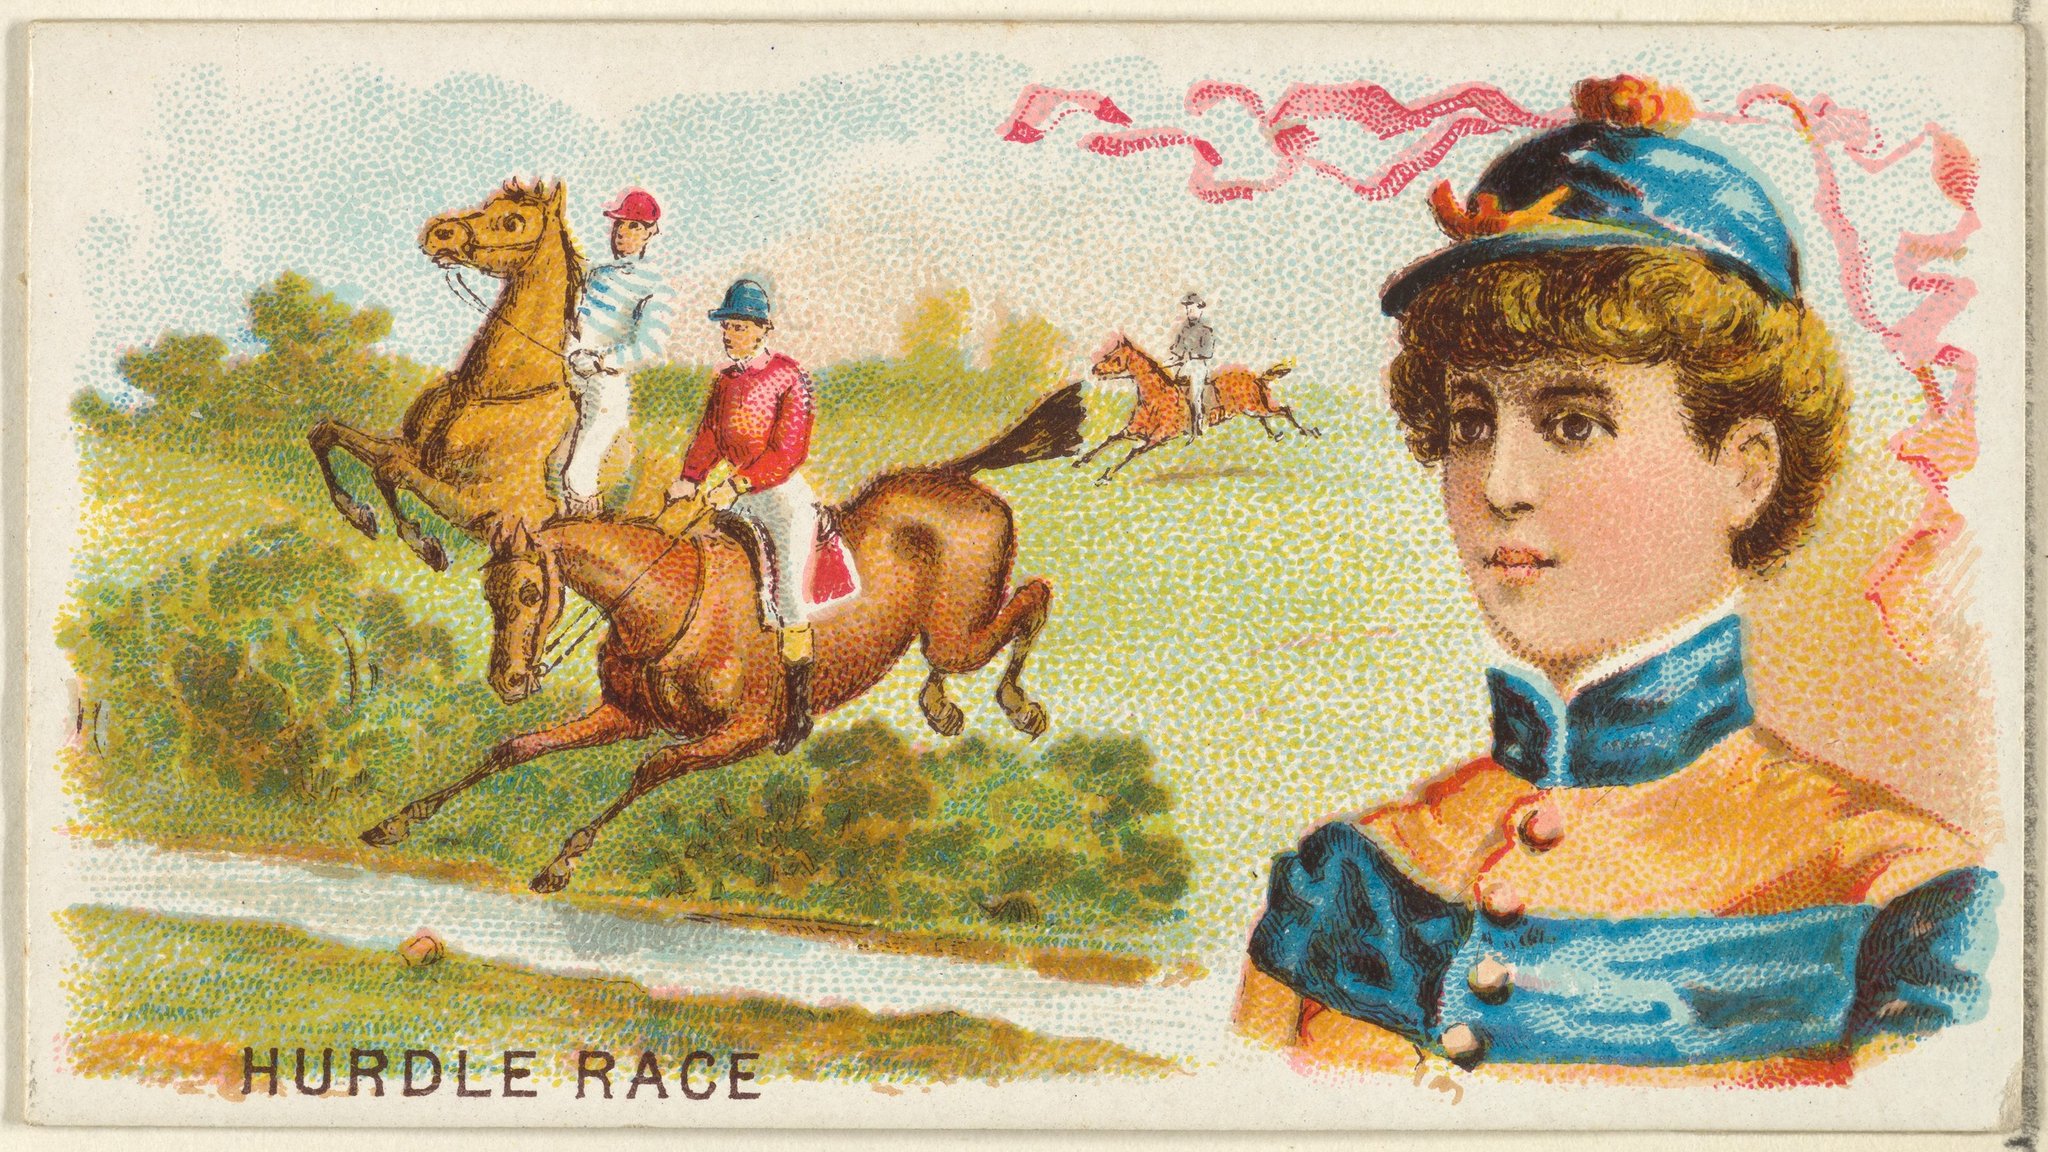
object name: print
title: Hurdle Race, from the Games and Sports series (N165) for Old Judge Cigarettes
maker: goodwin & company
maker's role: publisher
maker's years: 1850-1950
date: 1889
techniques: color lithograph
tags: sports,horses,athletes,jockeys